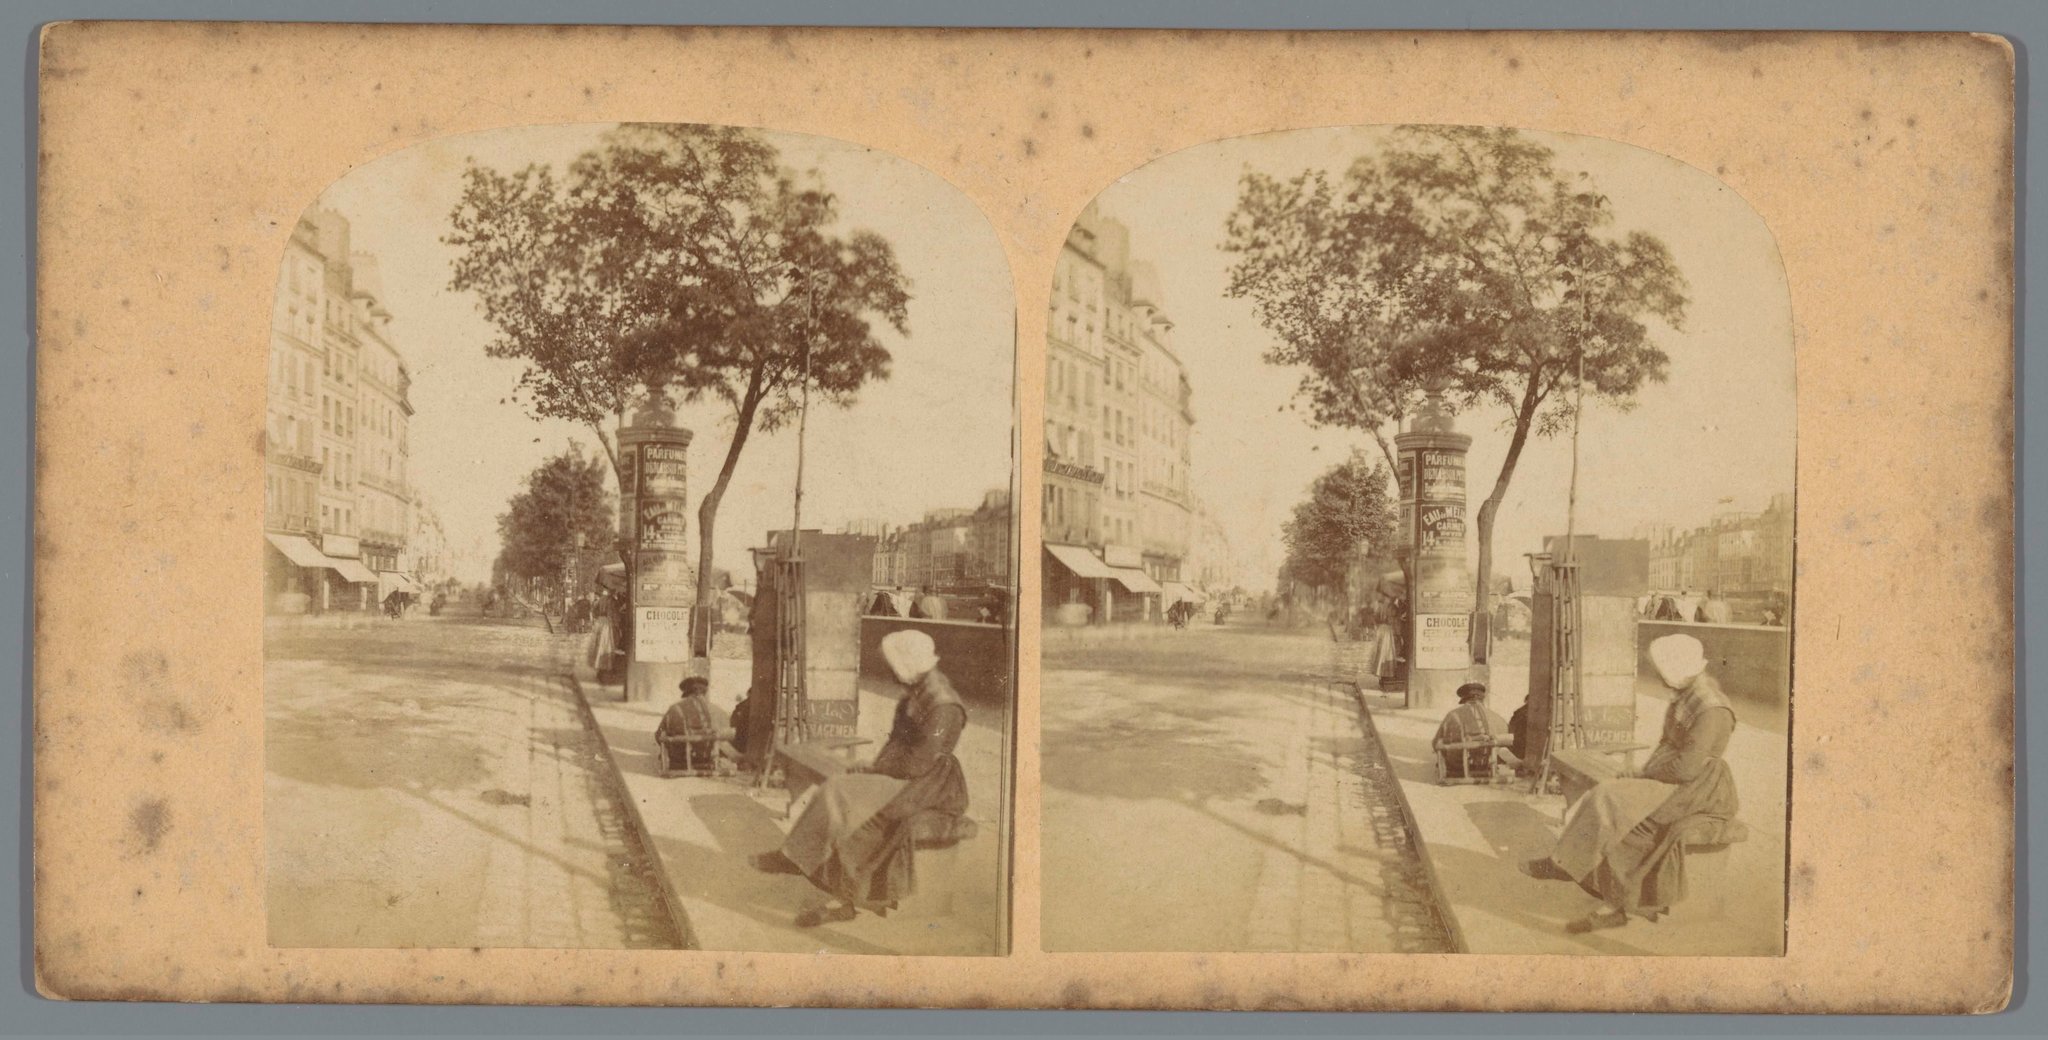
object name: stereograph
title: Kade in Parijs met een vrouw zittend op een bank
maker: Anonymous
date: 1850-1880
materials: cardboard, photographic support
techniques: albumen print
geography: paris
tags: quay, paris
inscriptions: inscription: ‘La quais’